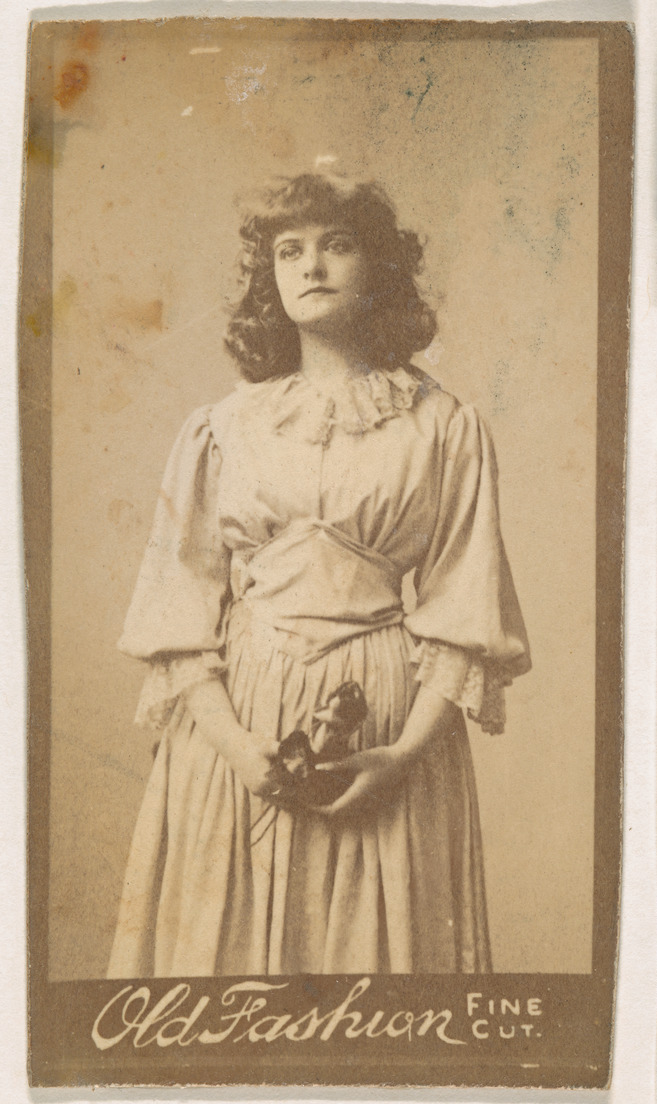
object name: photograph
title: Portrait of actress, from the Actresses series (N664) promoting Old Fashion Fine Cut Tobacco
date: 1888-1890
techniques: albumen silver print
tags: portraits,women,actresses